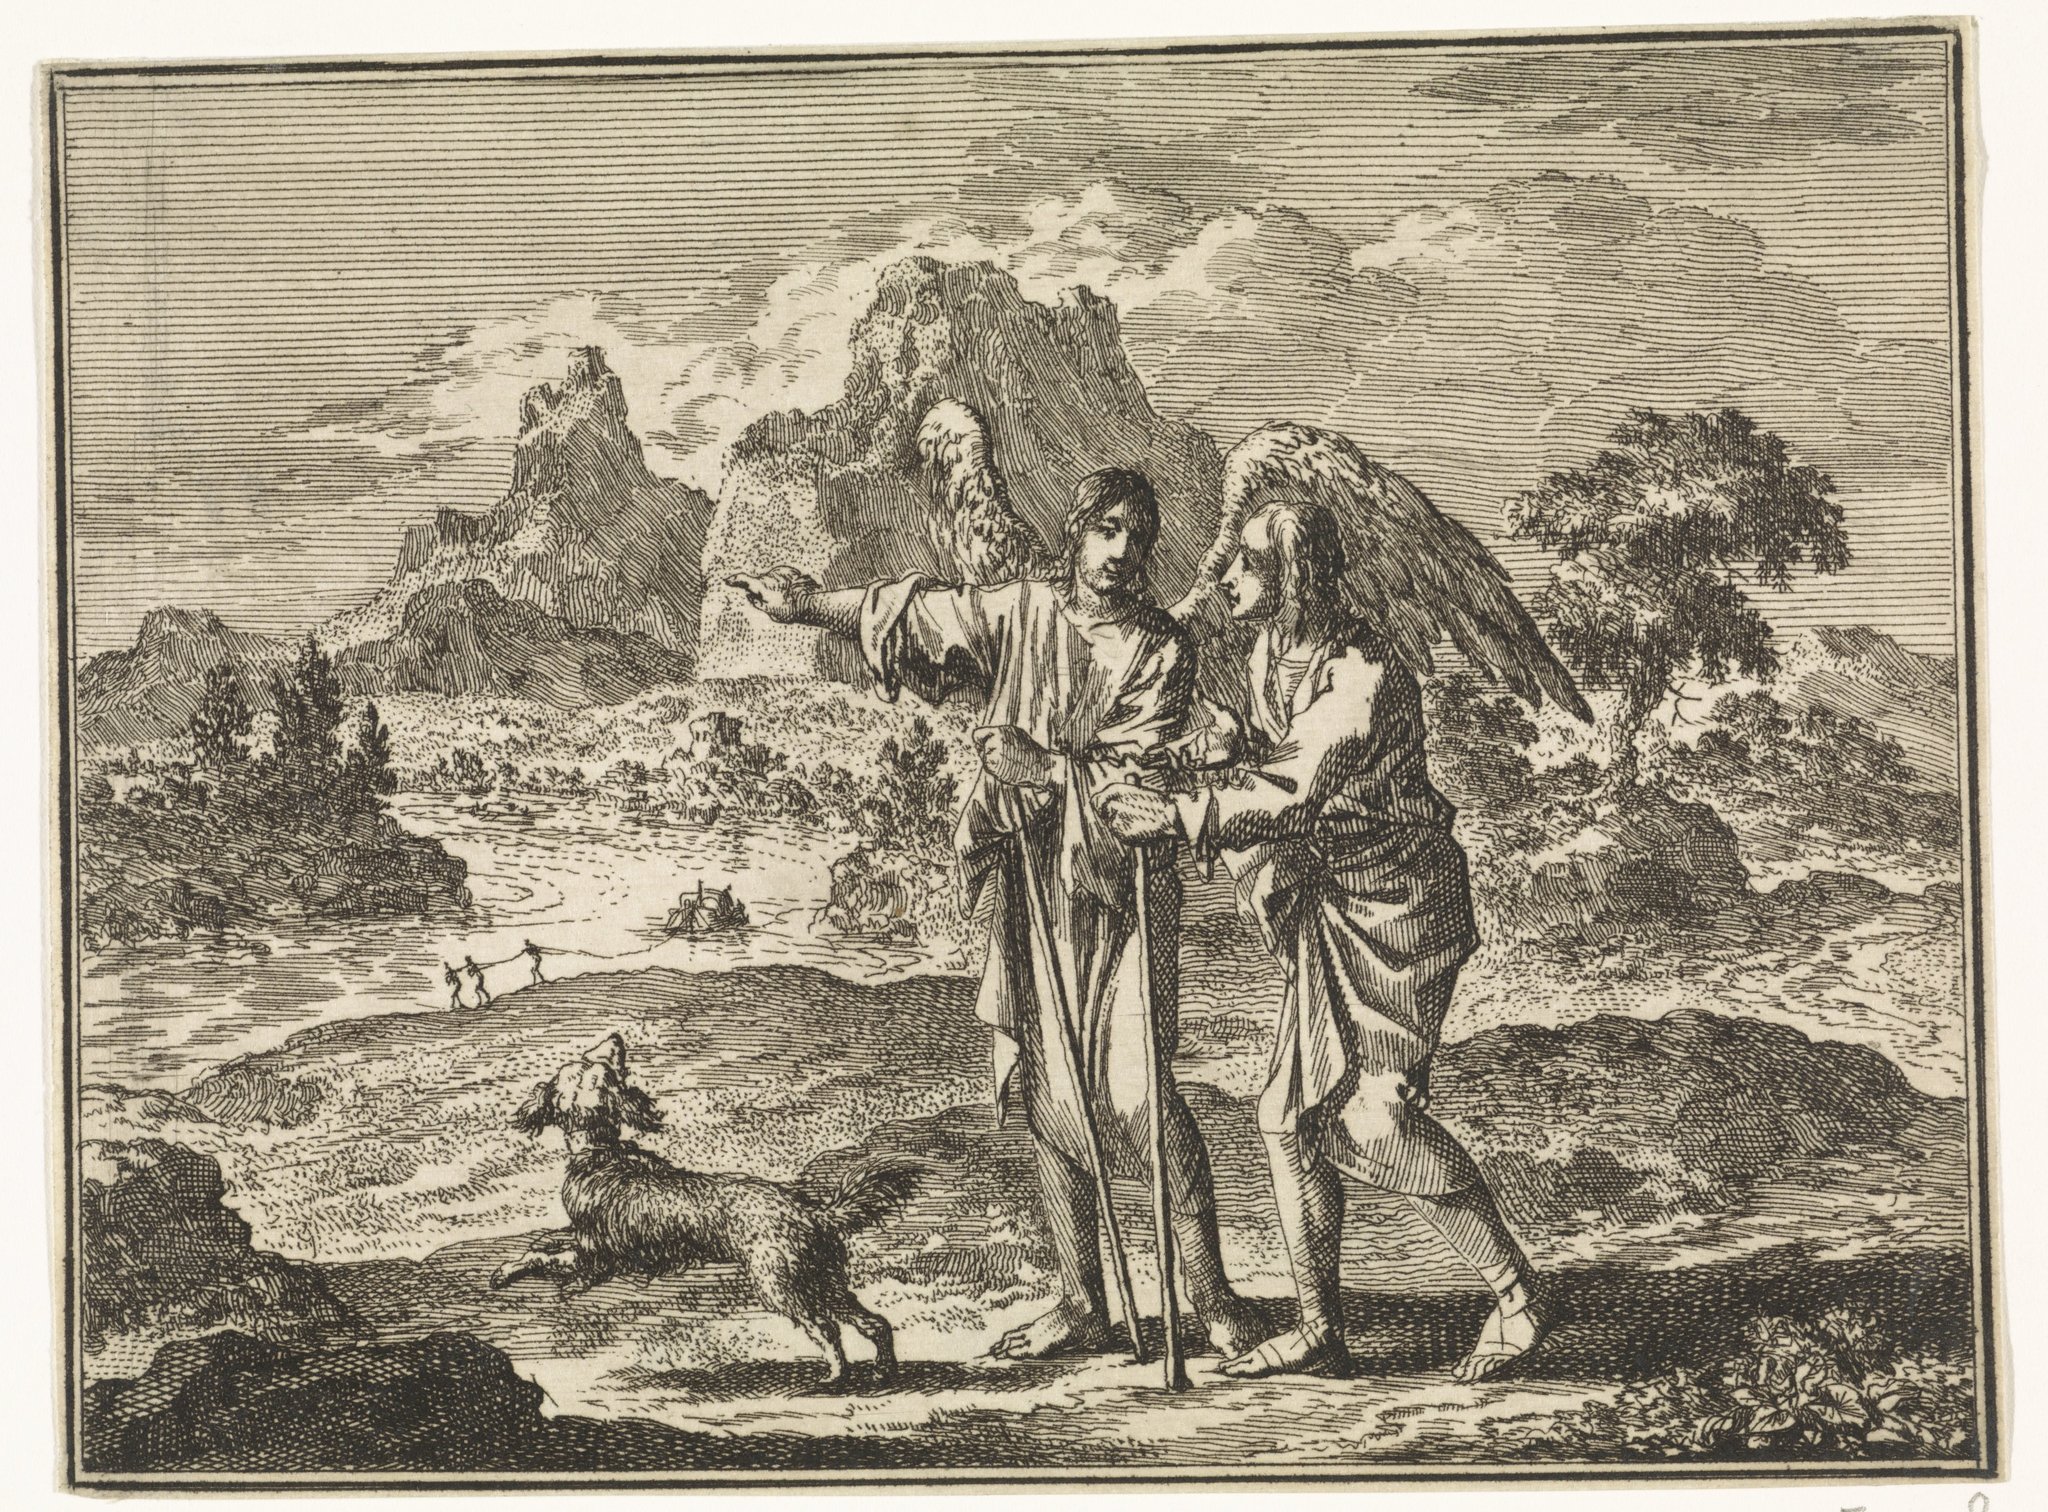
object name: print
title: Tobias en de engel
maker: jan luyken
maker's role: draughtsman, print maker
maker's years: 1649-1712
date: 1712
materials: paper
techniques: etching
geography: amsterdam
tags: tobias and the angel raphael travelling, accompanied by tobias' dog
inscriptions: number: ‘178’, collector's mark: Lugt 2228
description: Illustratie uit: Luyken, Jan. De schriftuurlyke geschiedenissen en gelykenissen van het Oude en Nieuwe Verbond, 2 delen. Amsterdam: Wed. Pieter Arentsz II en Cornelis van der Sys, 1712, dl. I.